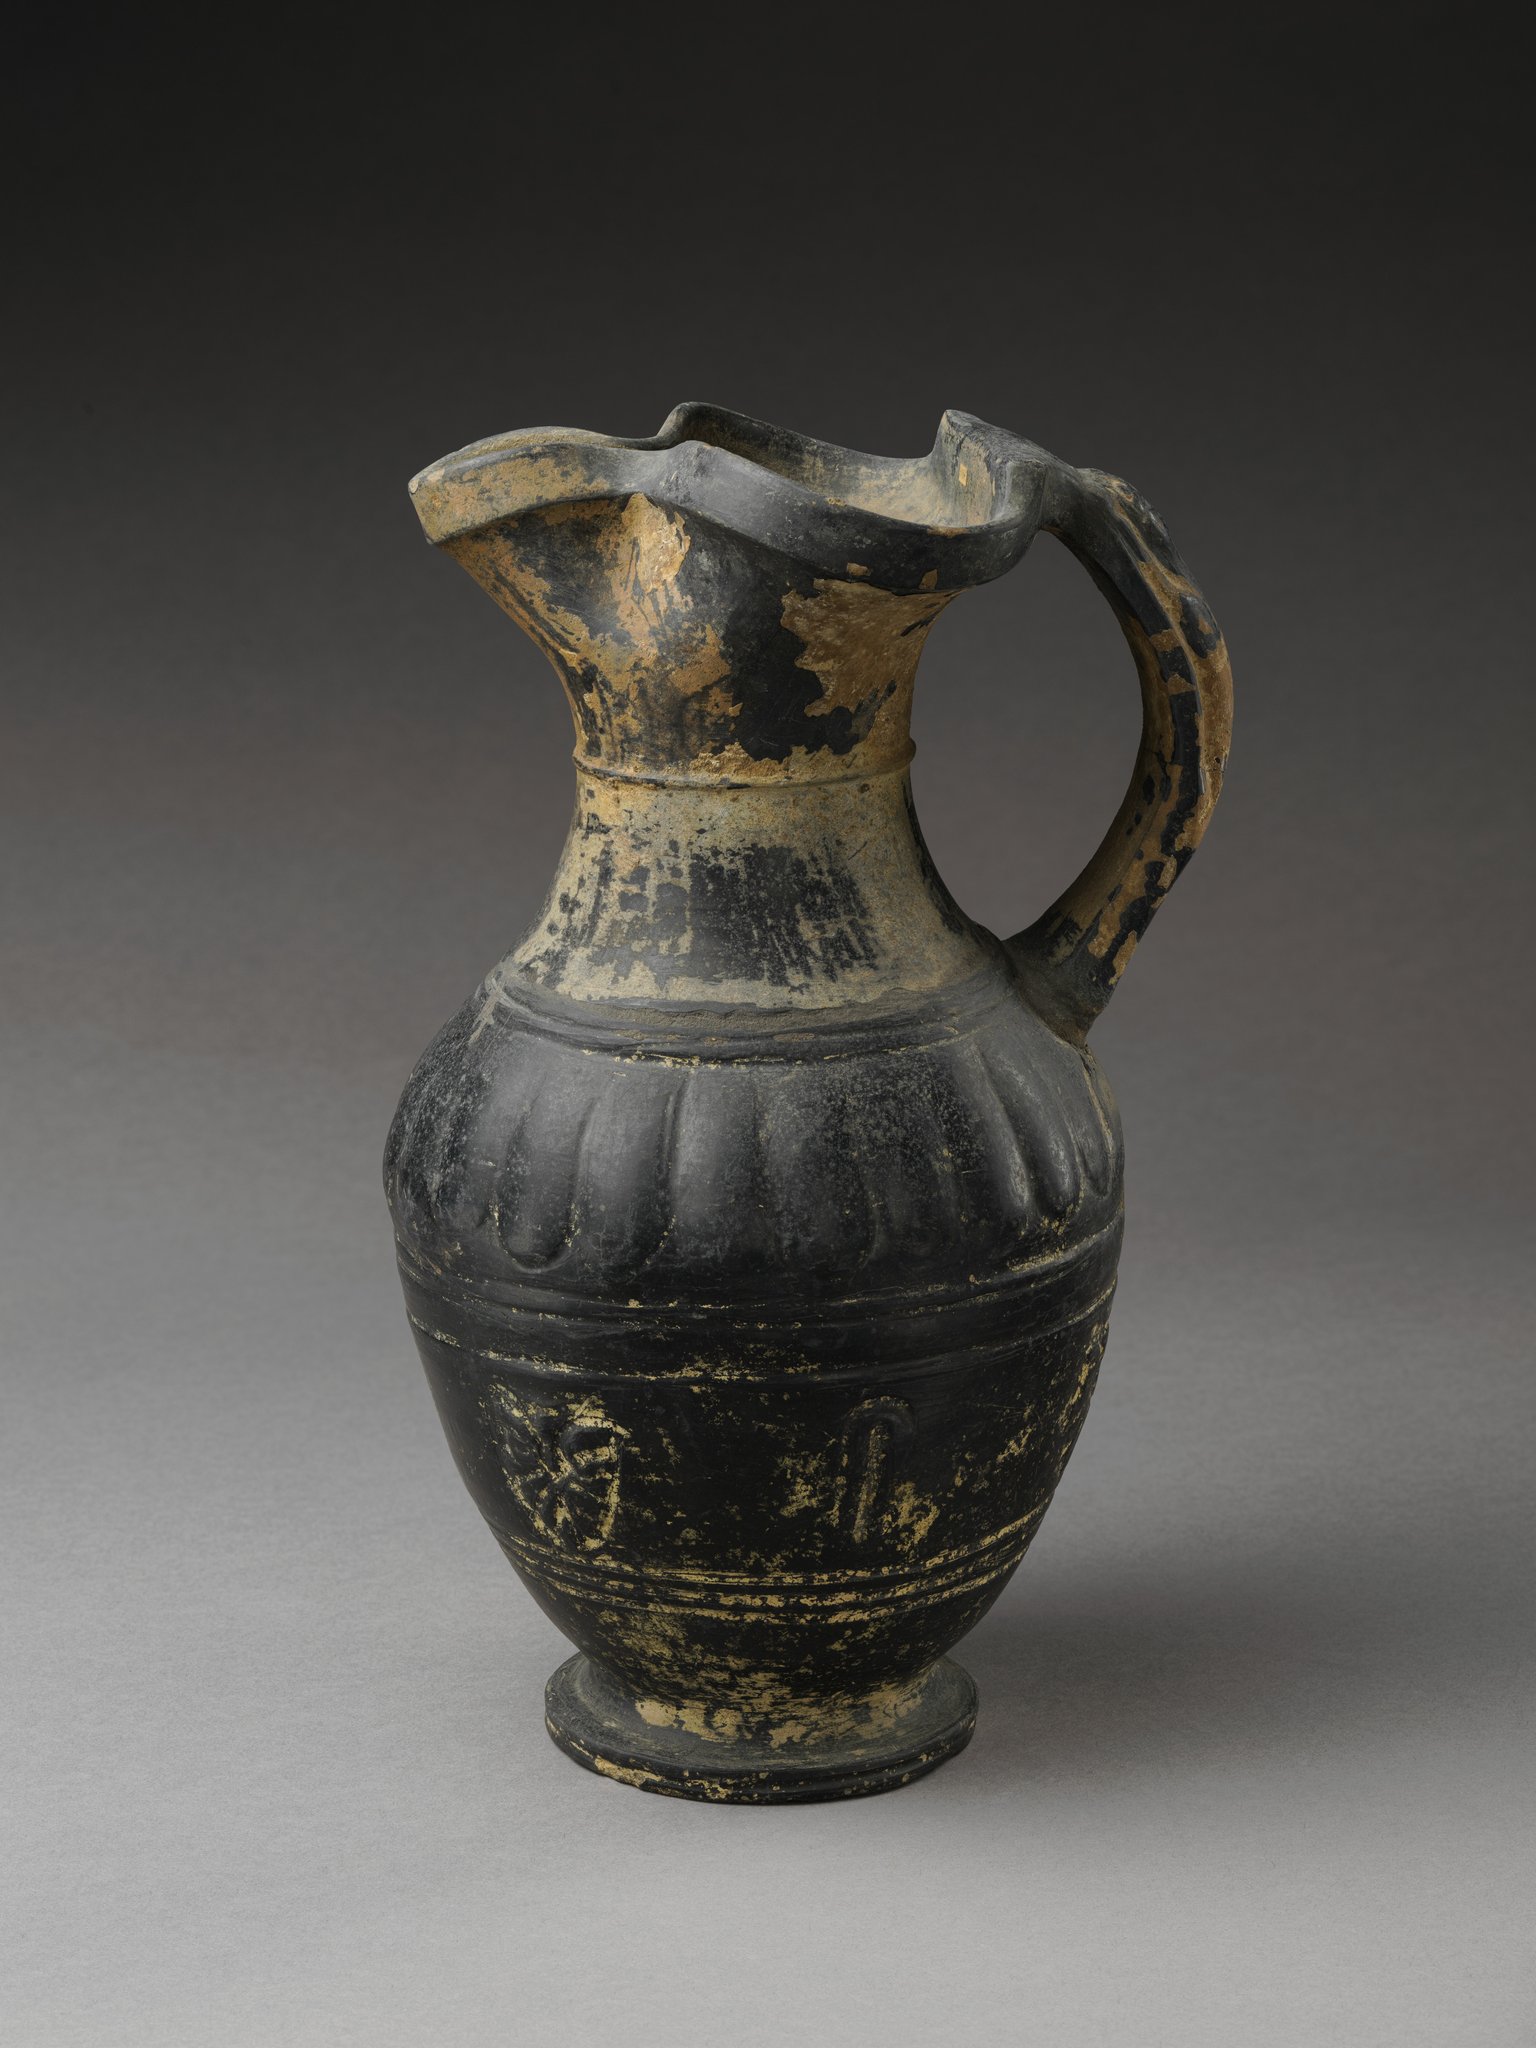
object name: jug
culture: etruscan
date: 600-301 BCE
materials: terracotta